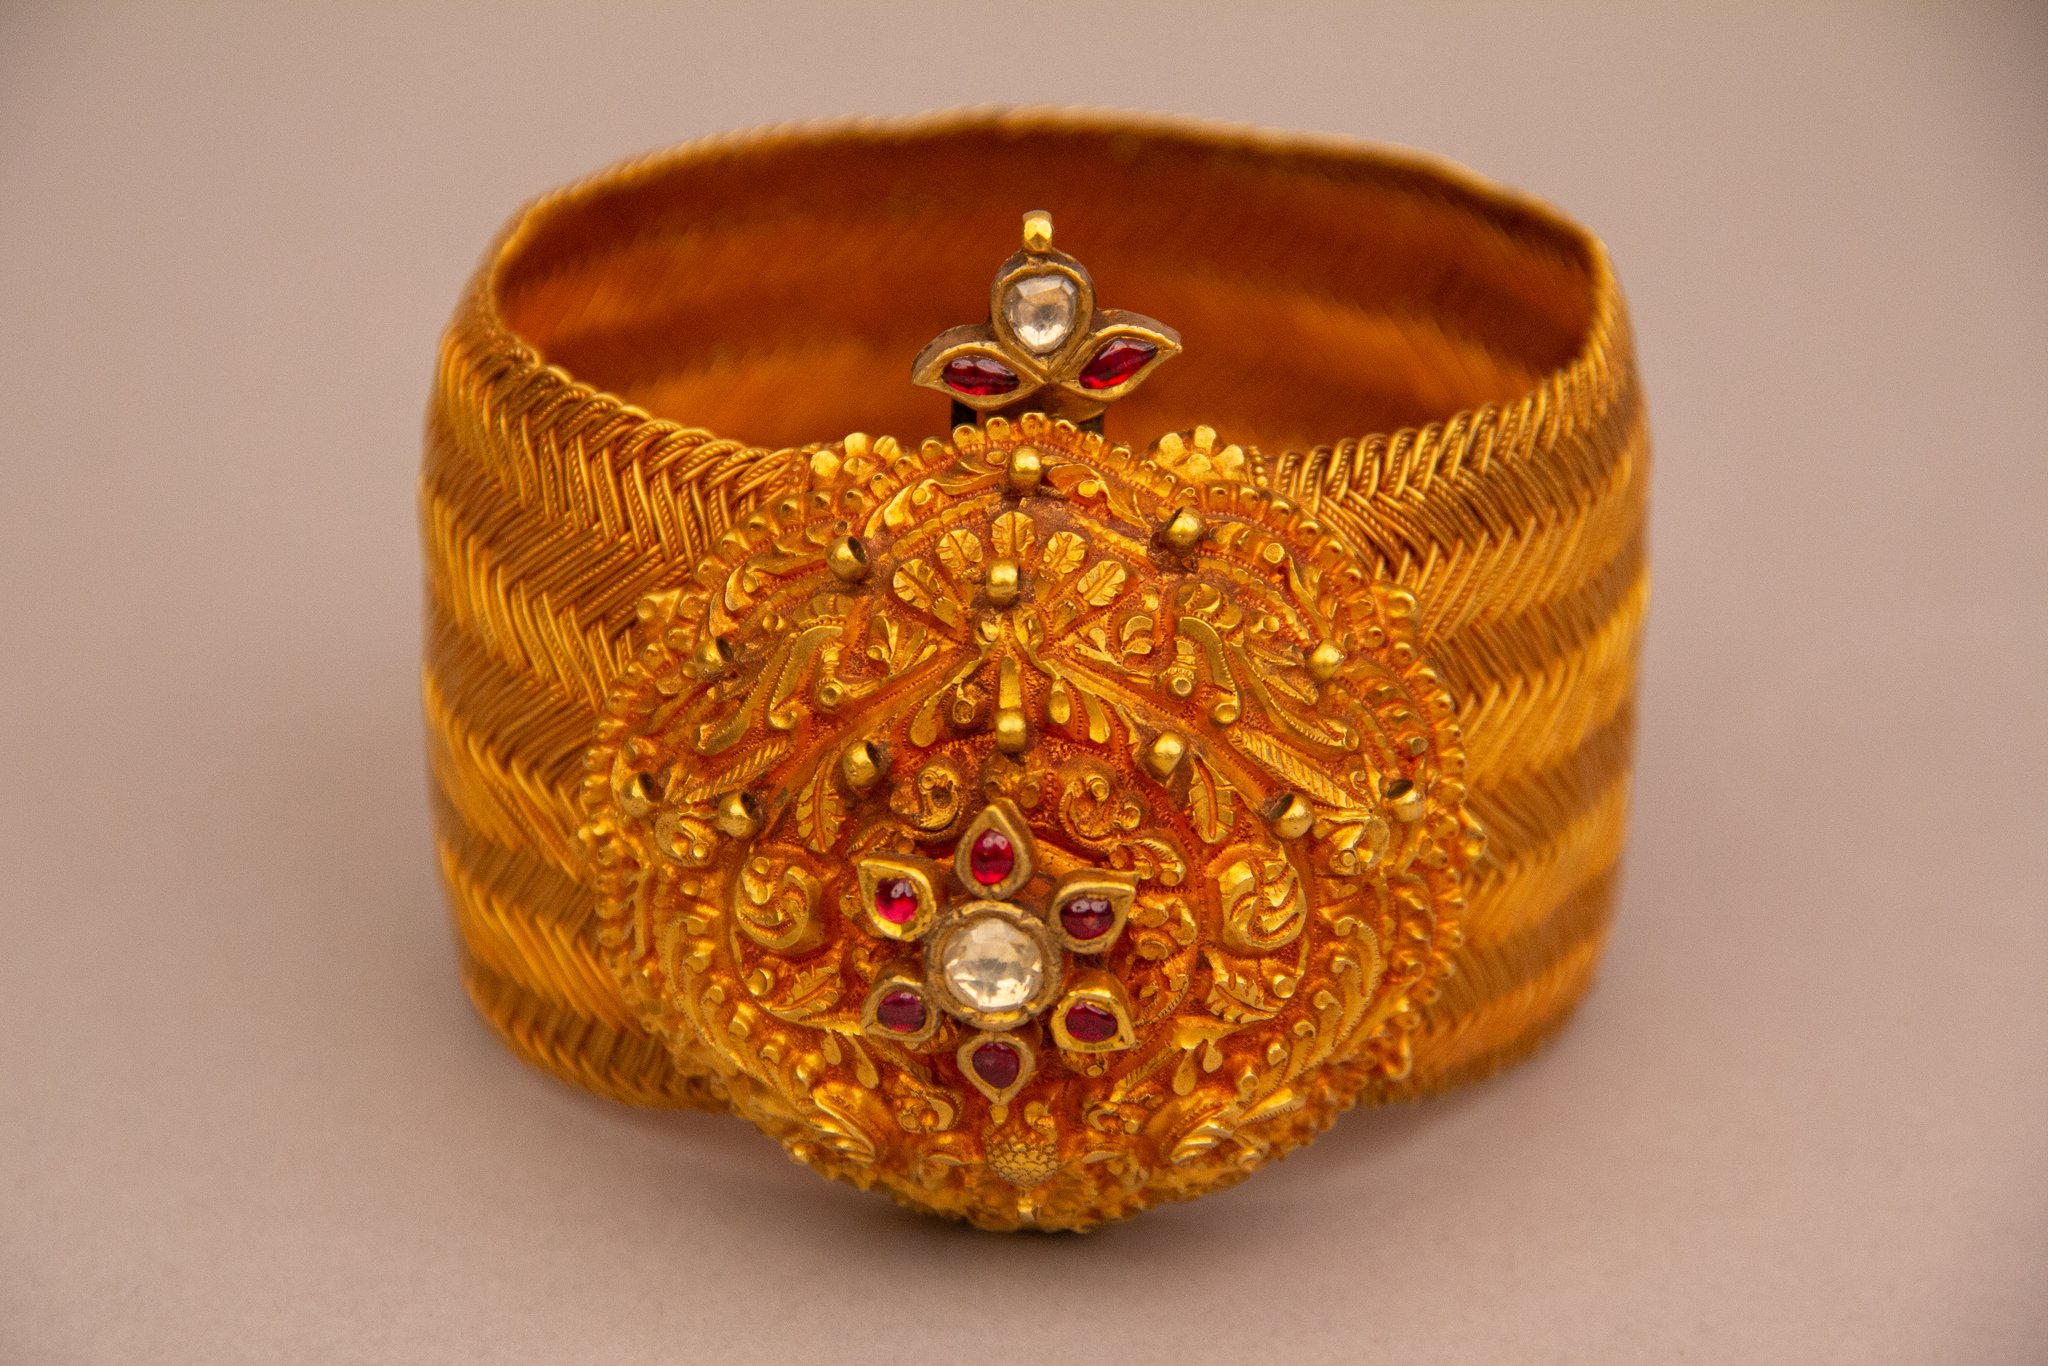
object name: armlet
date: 1801-1900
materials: gold, stone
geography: india